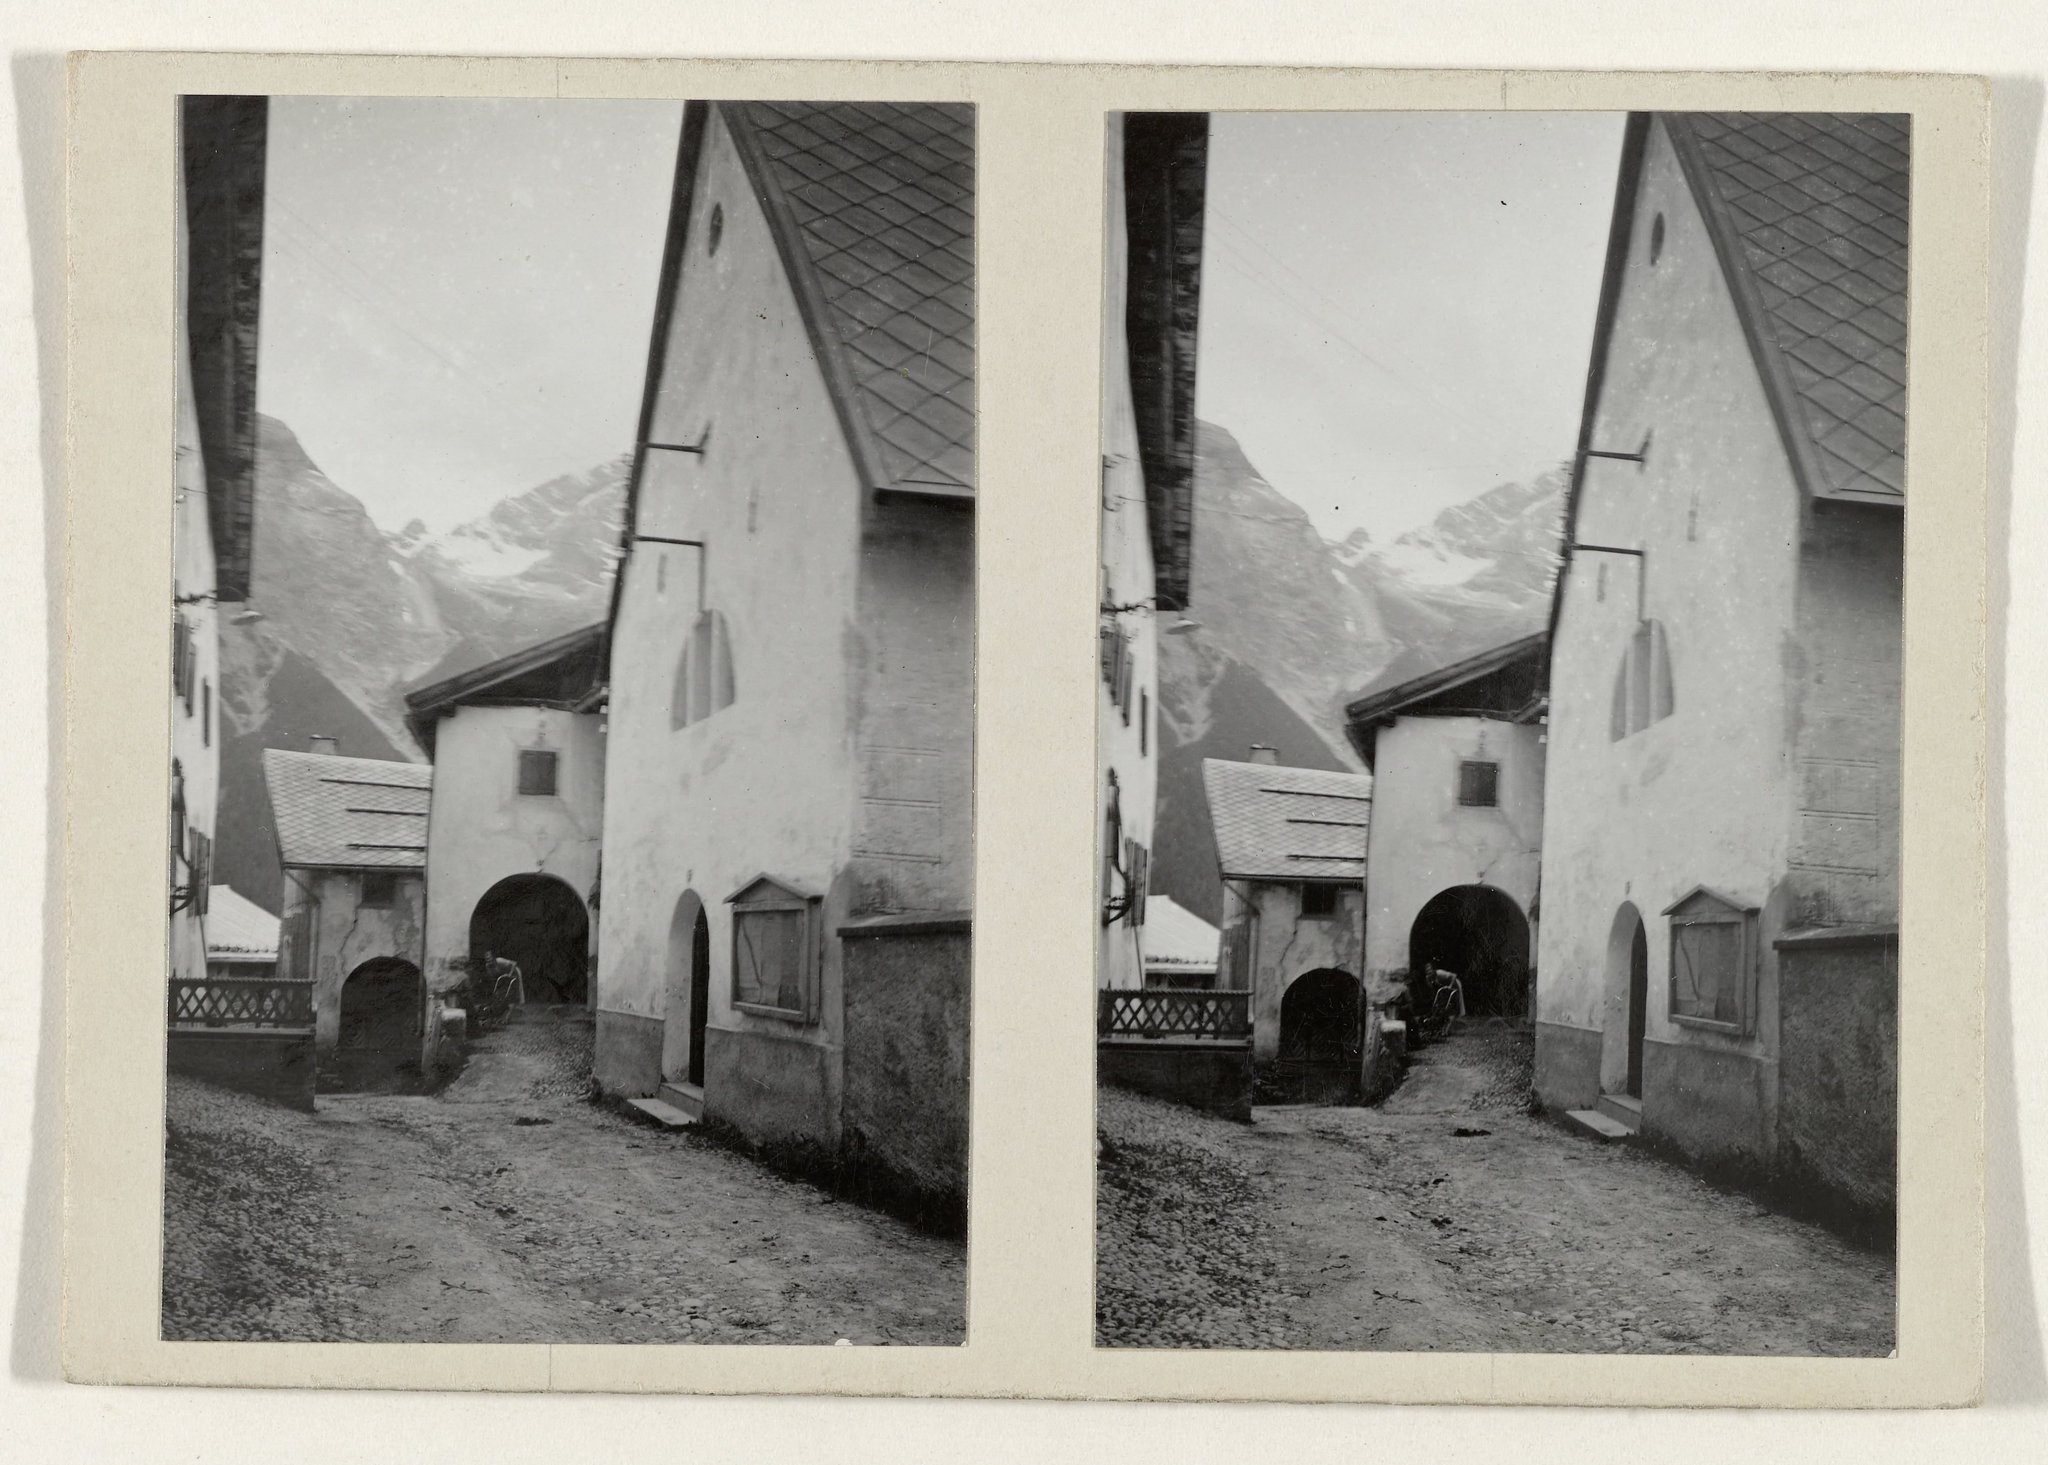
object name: stereograph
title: Tiroler woning met doorkijk naar een besneeuwd berglandschap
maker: geldolph adriaan kessler (dolph)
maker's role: fotograaf, industrieel, voetballer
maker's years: 1884-1945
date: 1920-1945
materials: paper, photographic support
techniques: collodion silver print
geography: netherlands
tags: tirol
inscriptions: title: ‘Latsch’